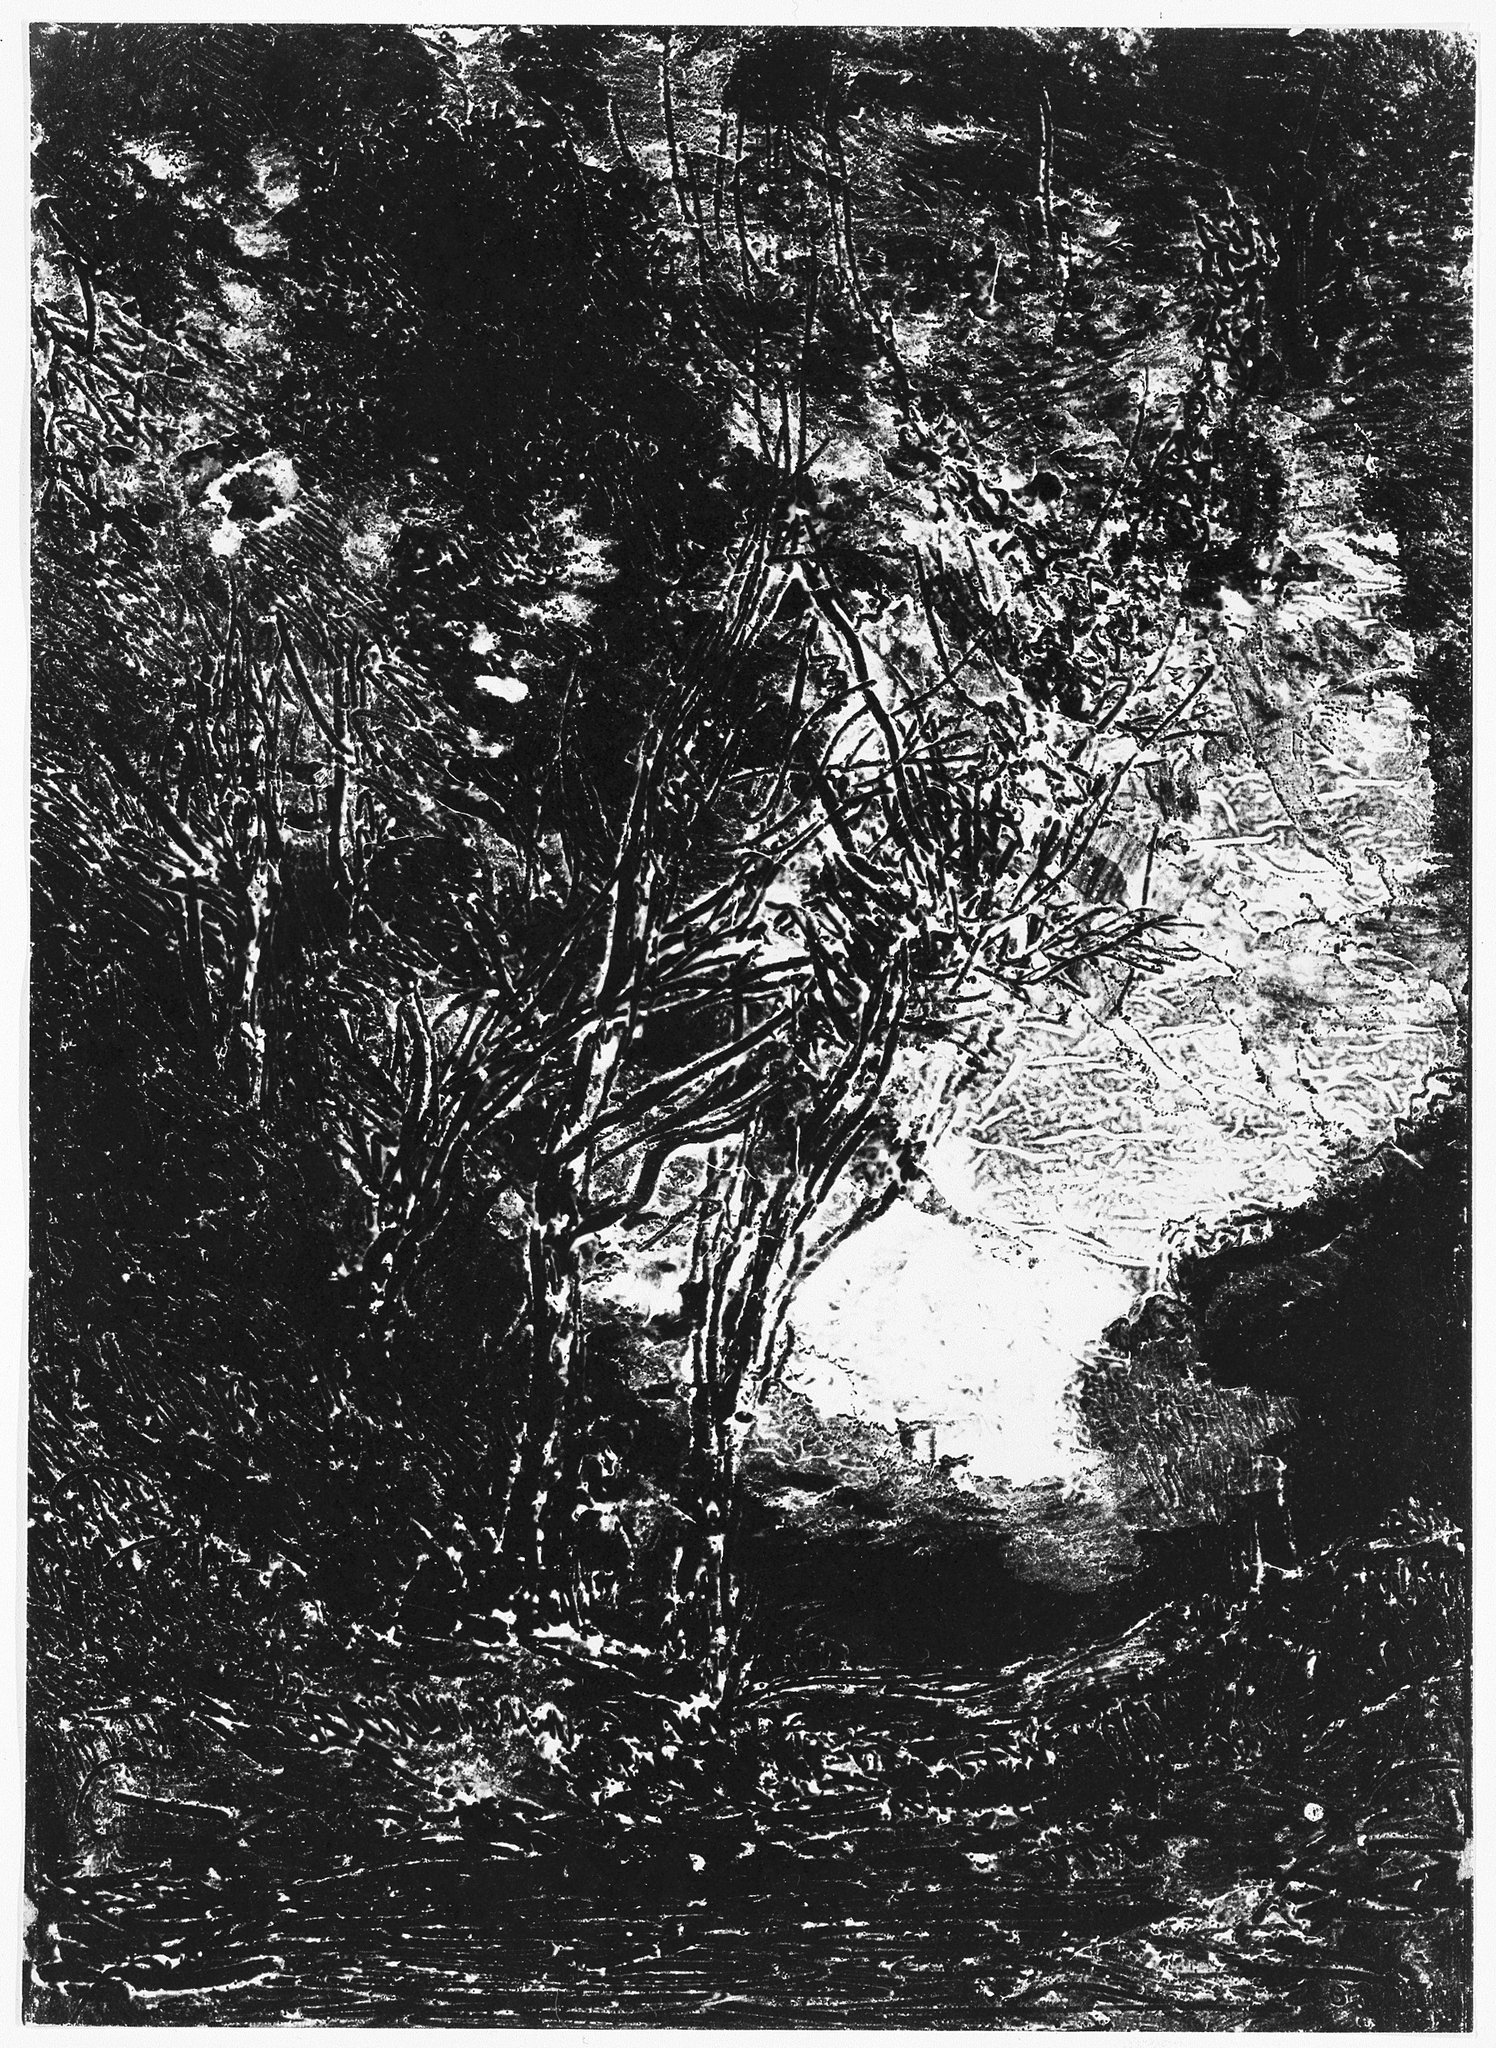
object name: print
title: The Ambush (L'Embuscade)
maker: jean-baptiste-camille corot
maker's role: artist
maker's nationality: french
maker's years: 1796-1875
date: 1858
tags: trees